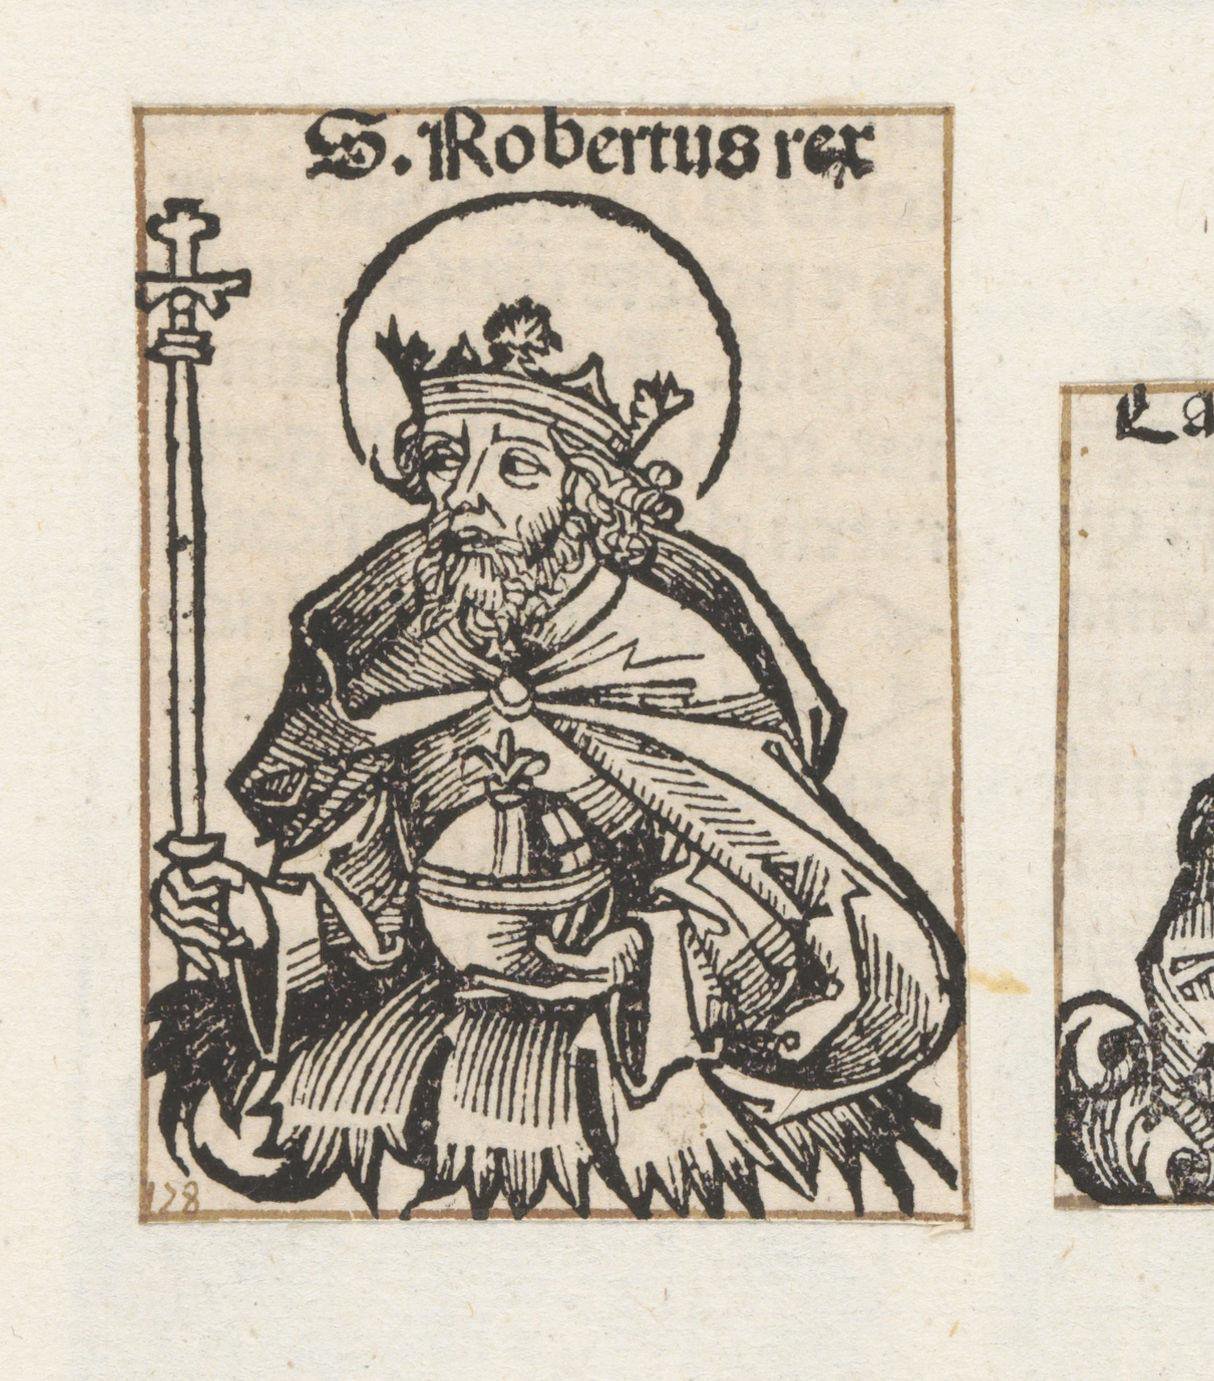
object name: album leaf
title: Koning Robert II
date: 1493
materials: paper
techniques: letterpress printing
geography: nuremberg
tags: king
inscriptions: inscription: ‘178’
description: Een bloemkelk met een koning. Hij heeft een scepter en een rijksappel in zijn handen. Om zijn hoofd een nimbus De tekst identificeert de man als de Franse koning Robert II. De prent maakt deel uit van een album.